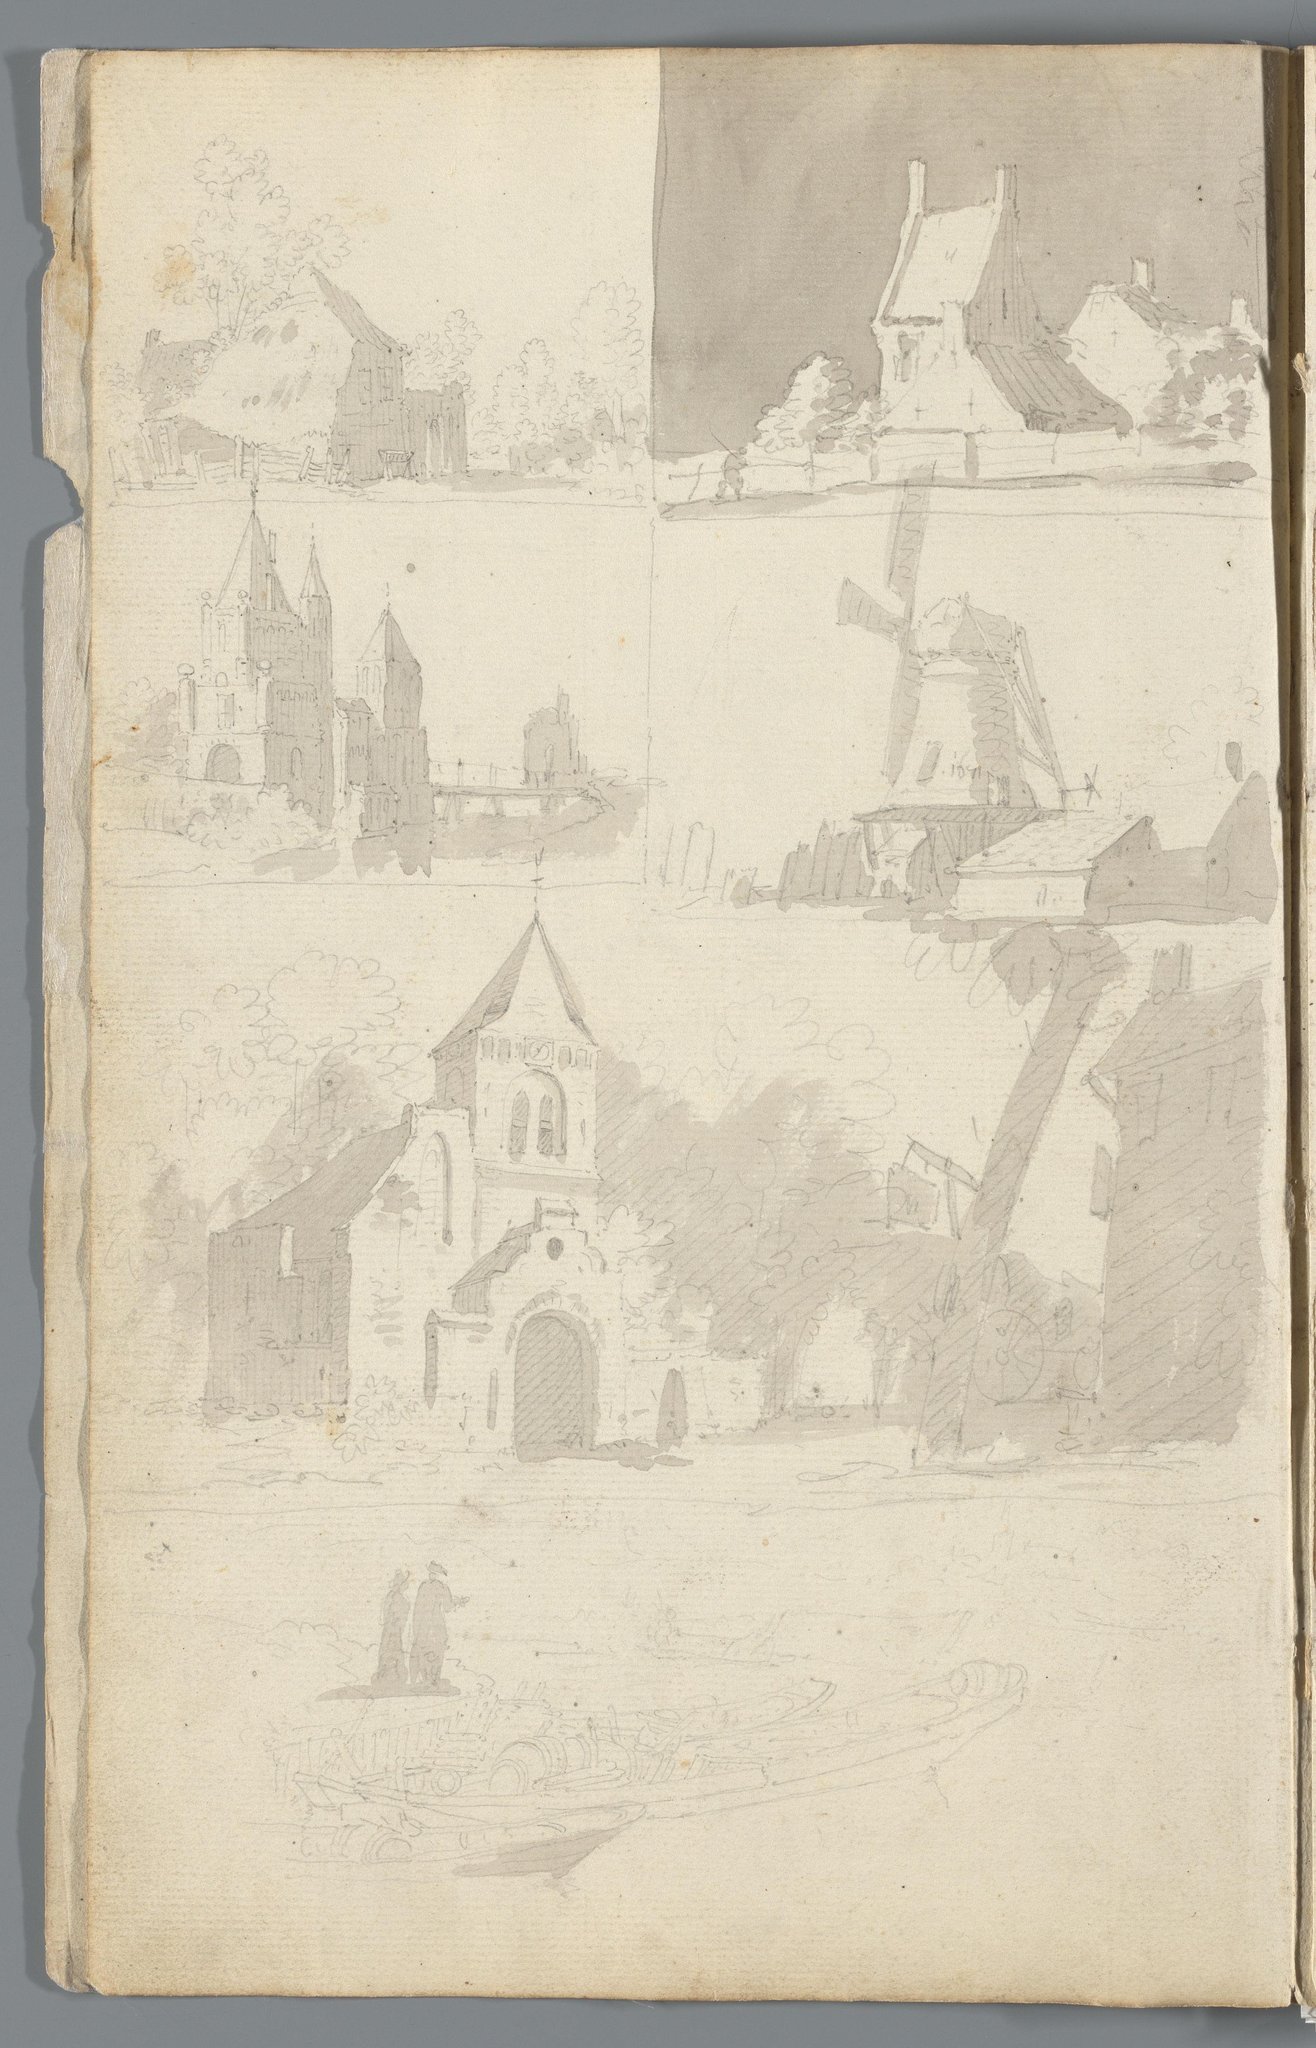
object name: sketchbook leaf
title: Huizen, een molen en een kerk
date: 1780-1800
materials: ink, paper, pencil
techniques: brush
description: Blad 2 verso uit een schetsboek met 17 bladen.